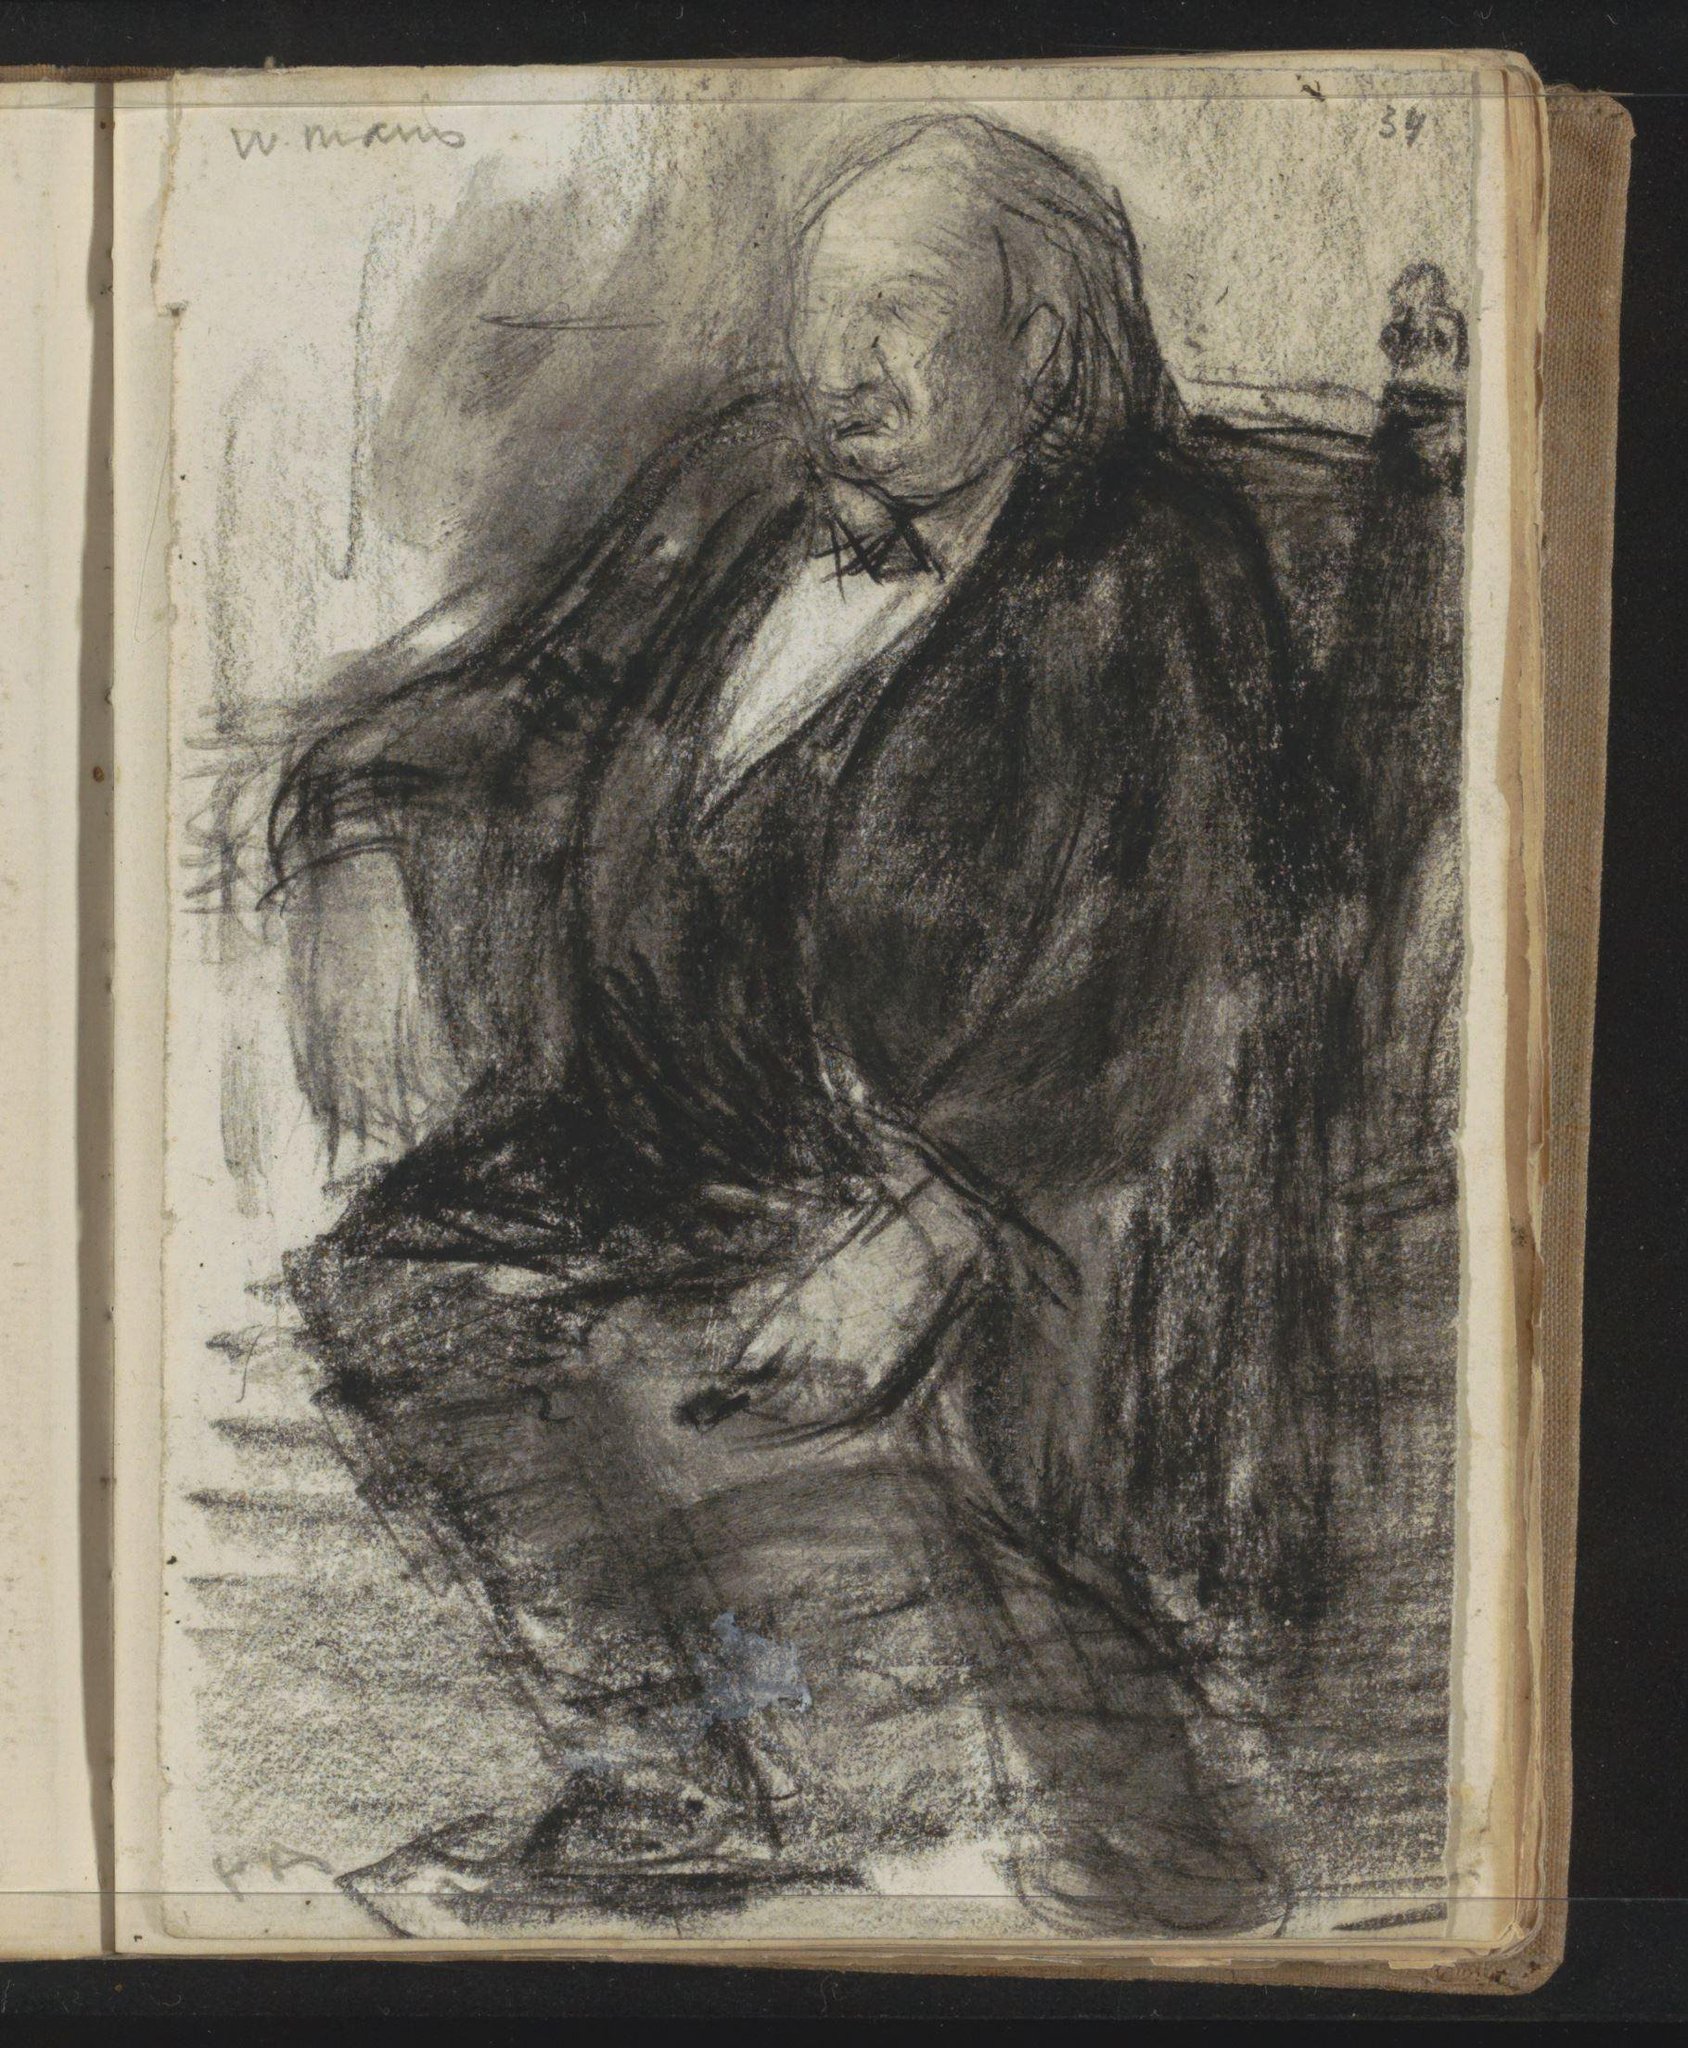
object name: sketchbook leaf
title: Portret van kunstenaar Willem Maris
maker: floris arntzenius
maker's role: draughtsman, print maker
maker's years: 1864-1925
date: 1883-1914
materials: chalk, paper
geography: the hague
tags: painter, willem maris, portrait, self-portrait of artist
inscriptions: name: ‘W. Maris’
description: Blad, geplakt op pagina 34 uit een schetsboek met 82 pagina's.